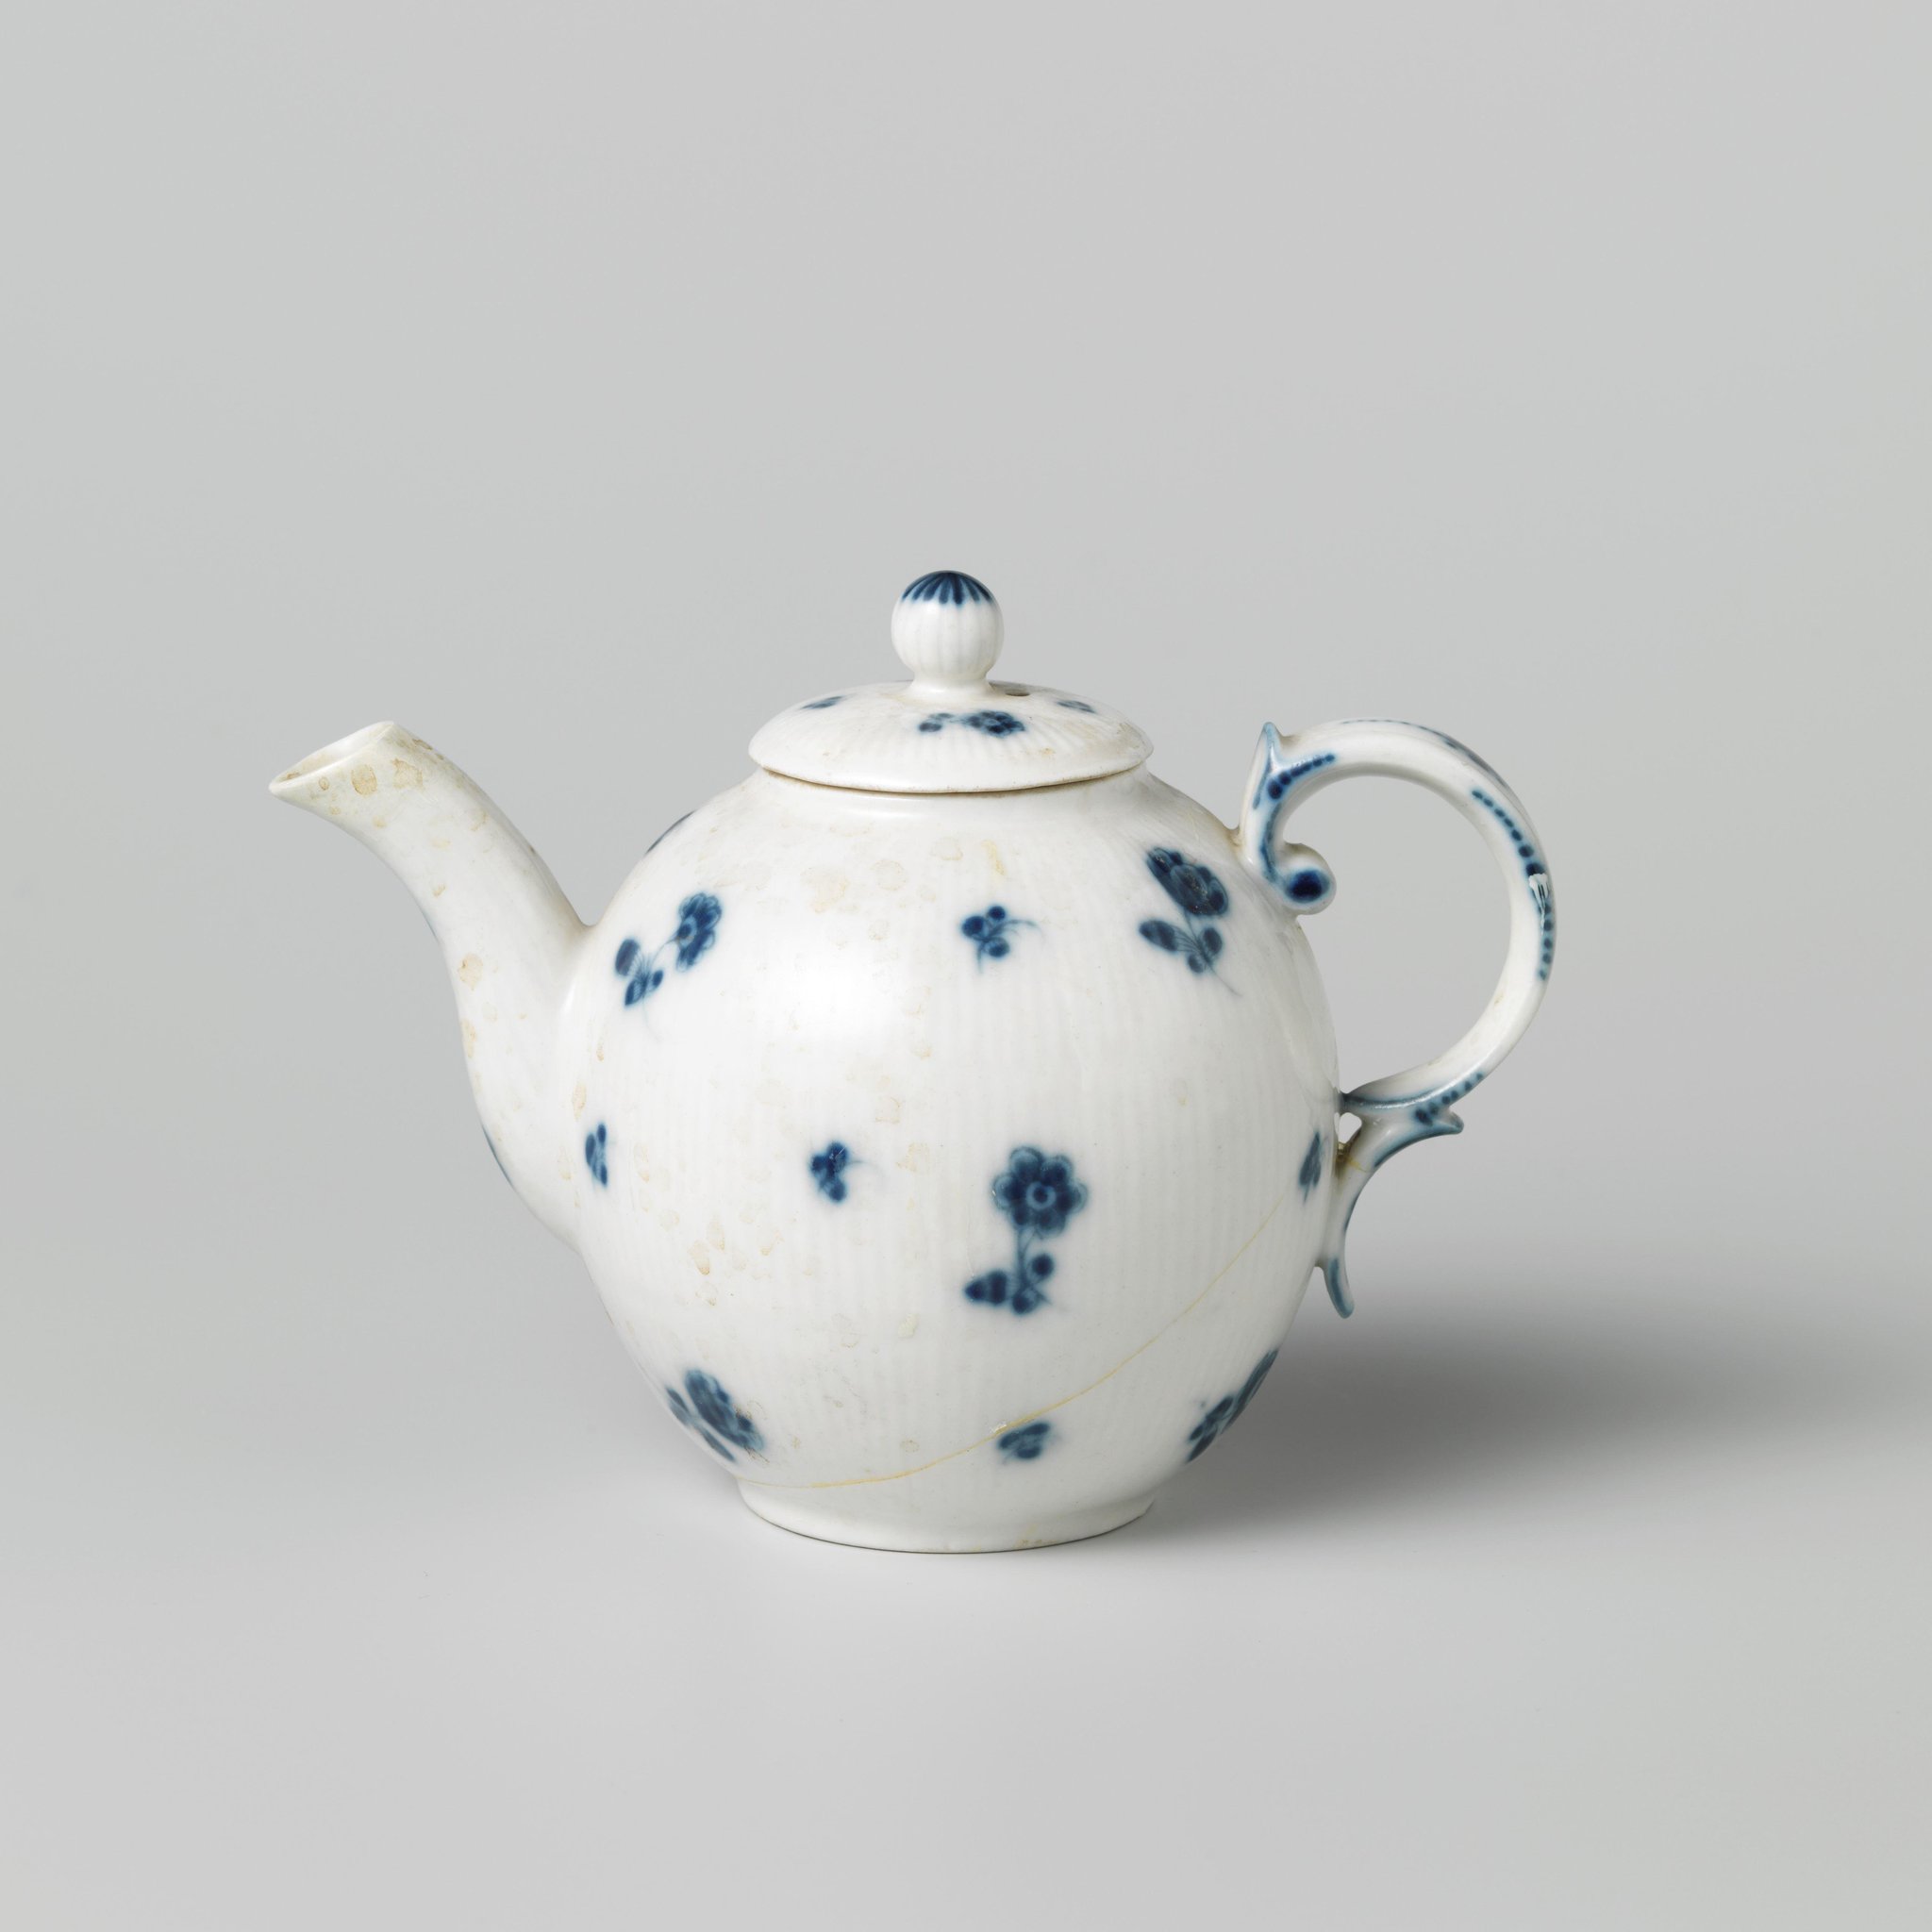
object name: teapot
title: Deksel van theepot, beschilderd met strooibloemen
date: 1784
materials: porcelain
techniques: painted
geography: loosdrecht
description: Deksel van een theepot geribd met een blauw strooipatroon van bloemen onder het glazuur.